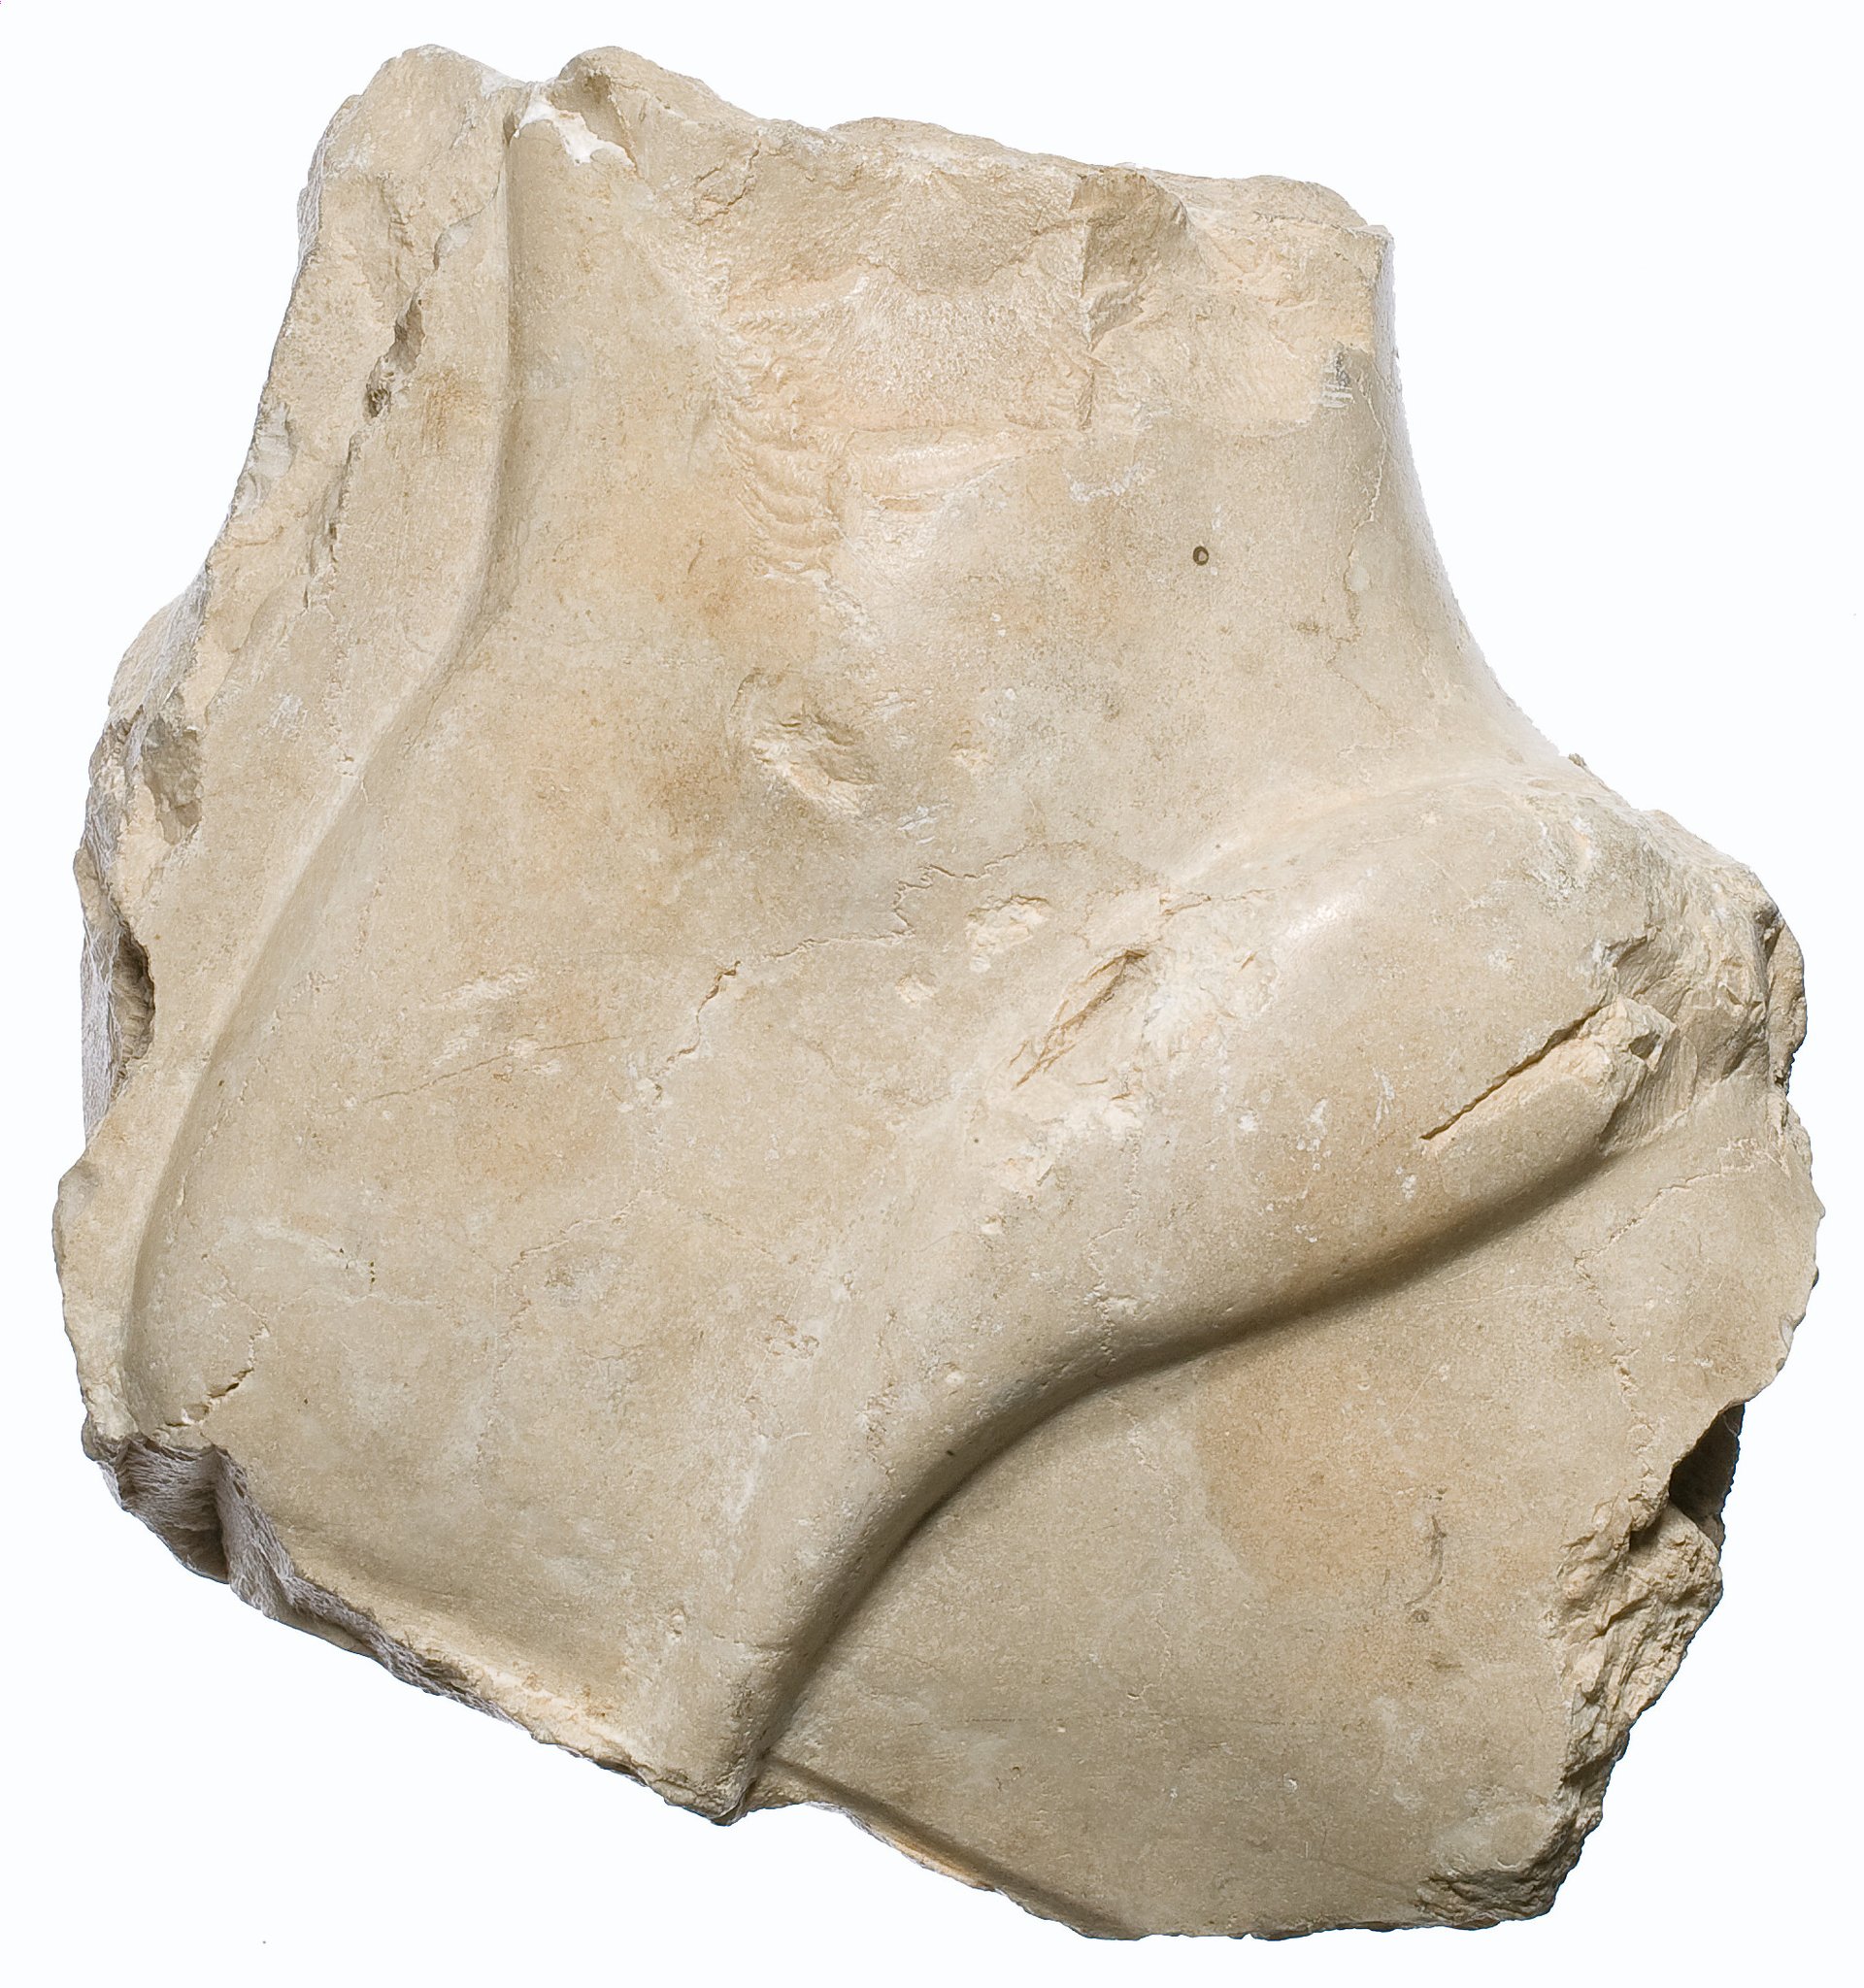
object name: foot fragment, striding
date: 1353-1336 BCE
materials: limestone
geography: egypt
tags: feet